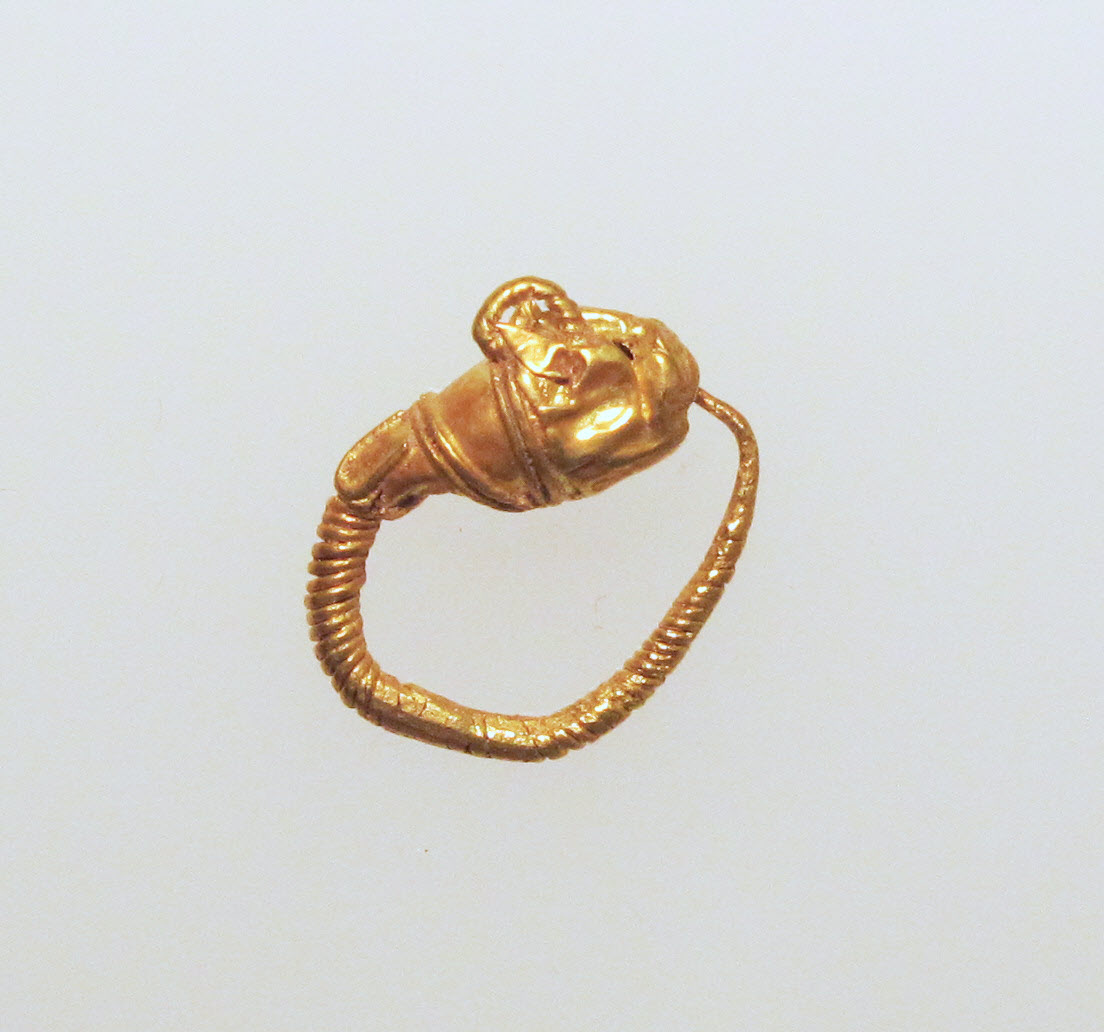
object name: earring with head of lion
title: Gold earring with head of a lion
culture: greek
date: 400-201 BCE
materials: gold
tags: lions